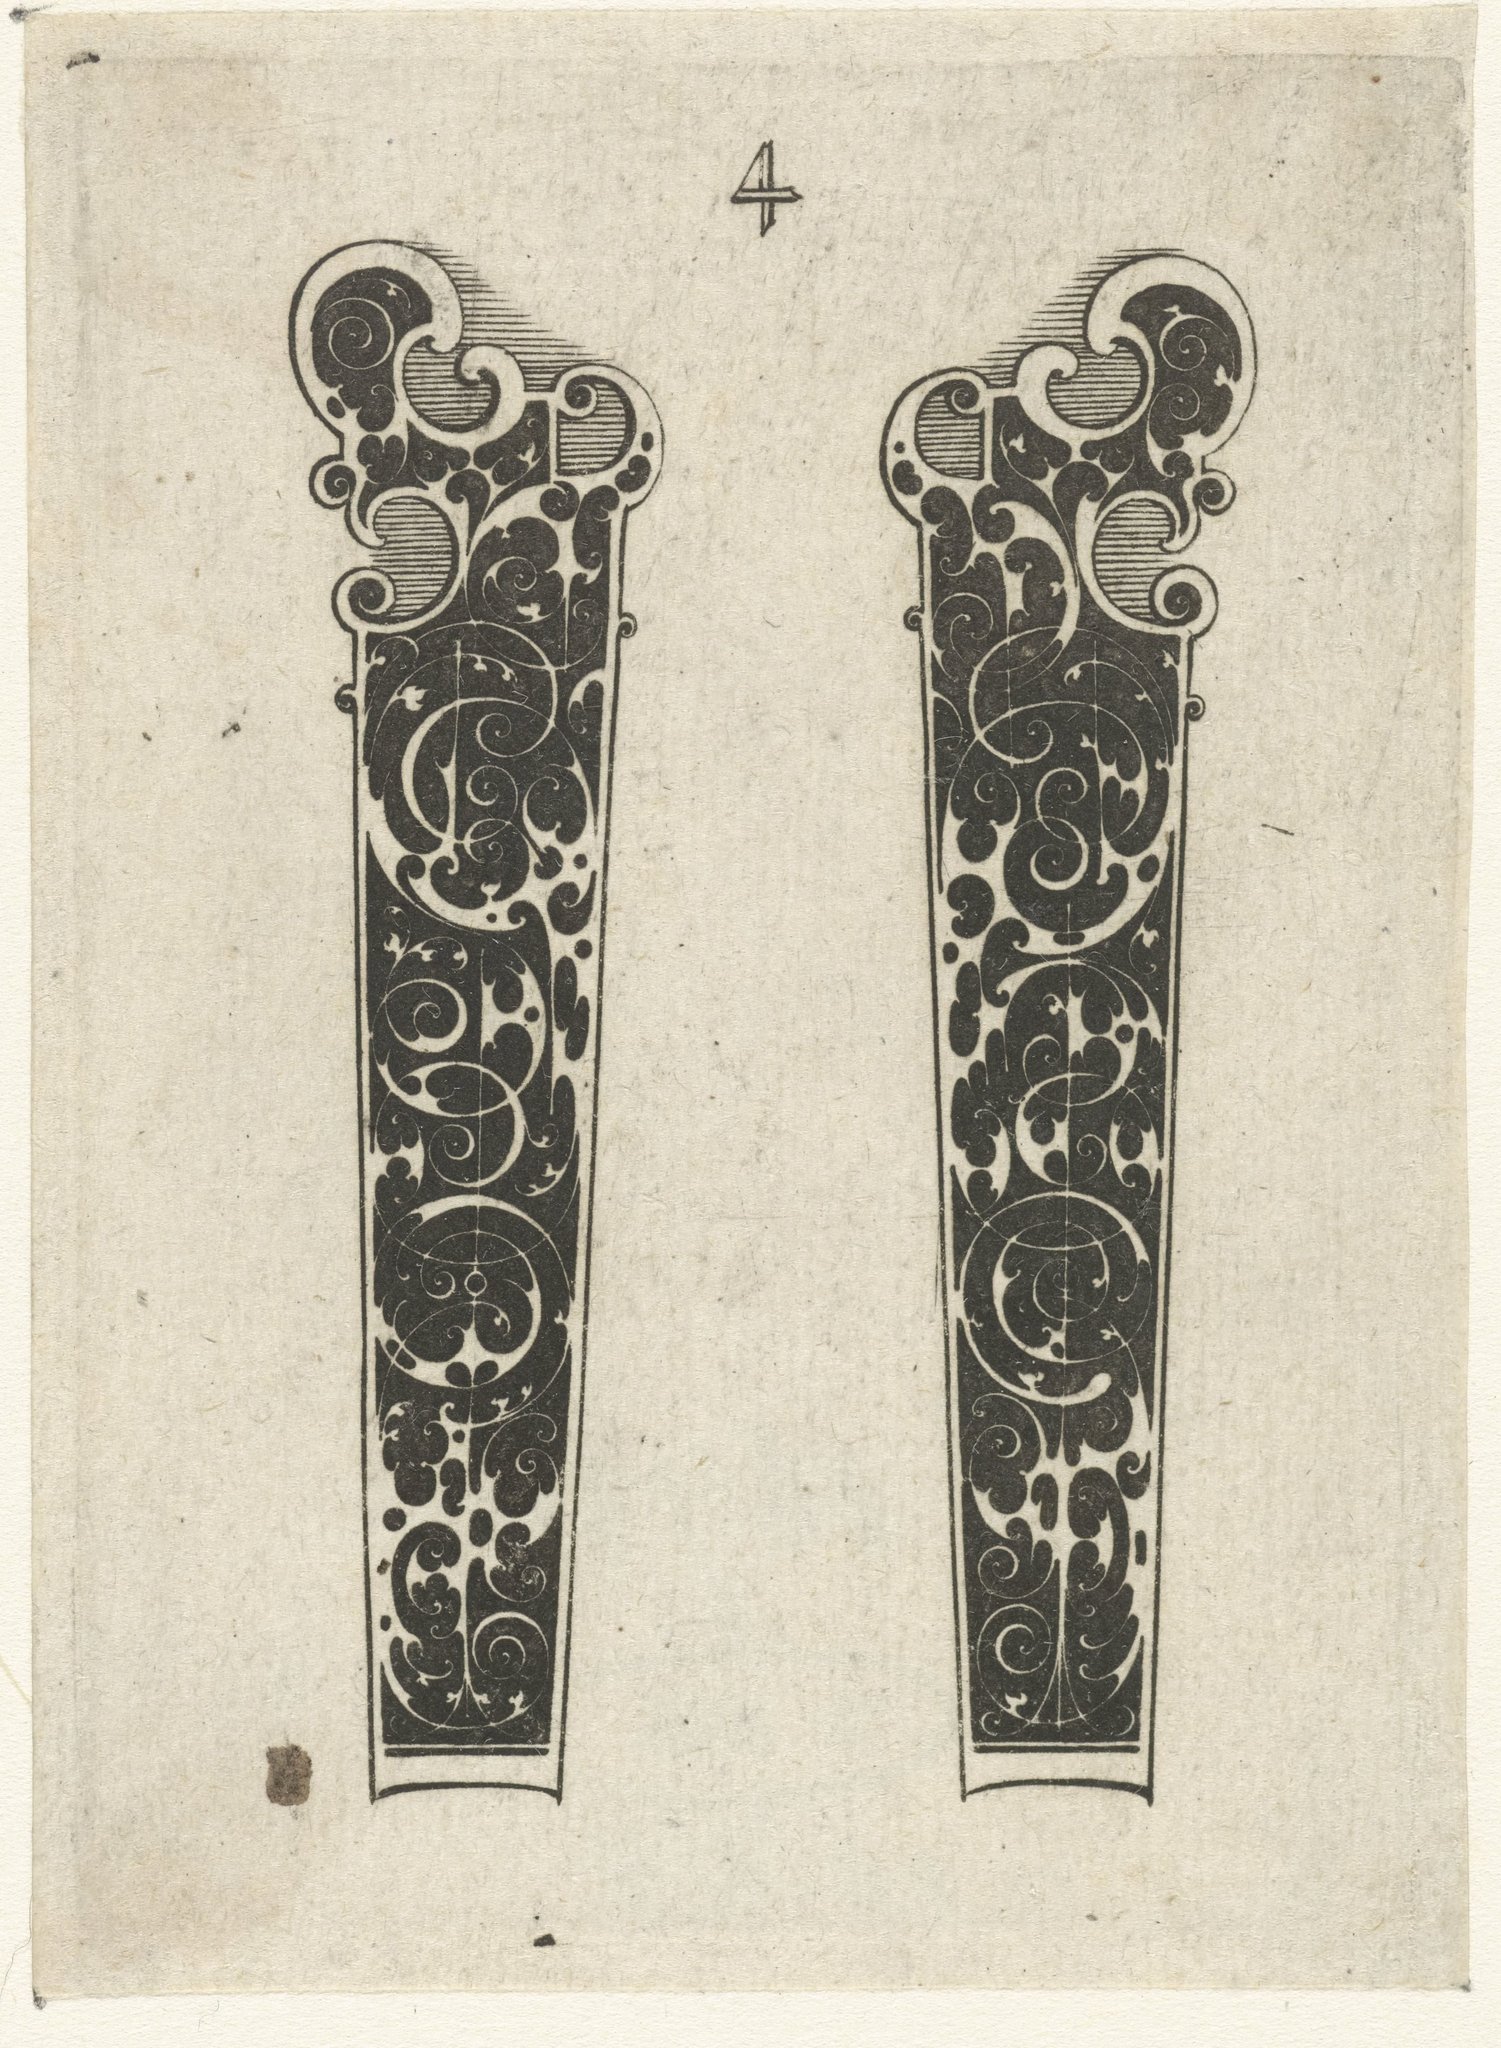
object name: ornament print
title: Twee messenheften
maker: michiel le blon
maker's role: print maker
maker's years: 1587-1656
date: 1597-1625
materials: paper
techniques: etching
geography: amsterdam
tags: table-knife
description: Op elk blad uit deze serie staan twee messenheften naast elkaar afgebeeld, gedecoreerd met Schweifwerk en gestileerde ranken in wit op een zwarte ondergrond.